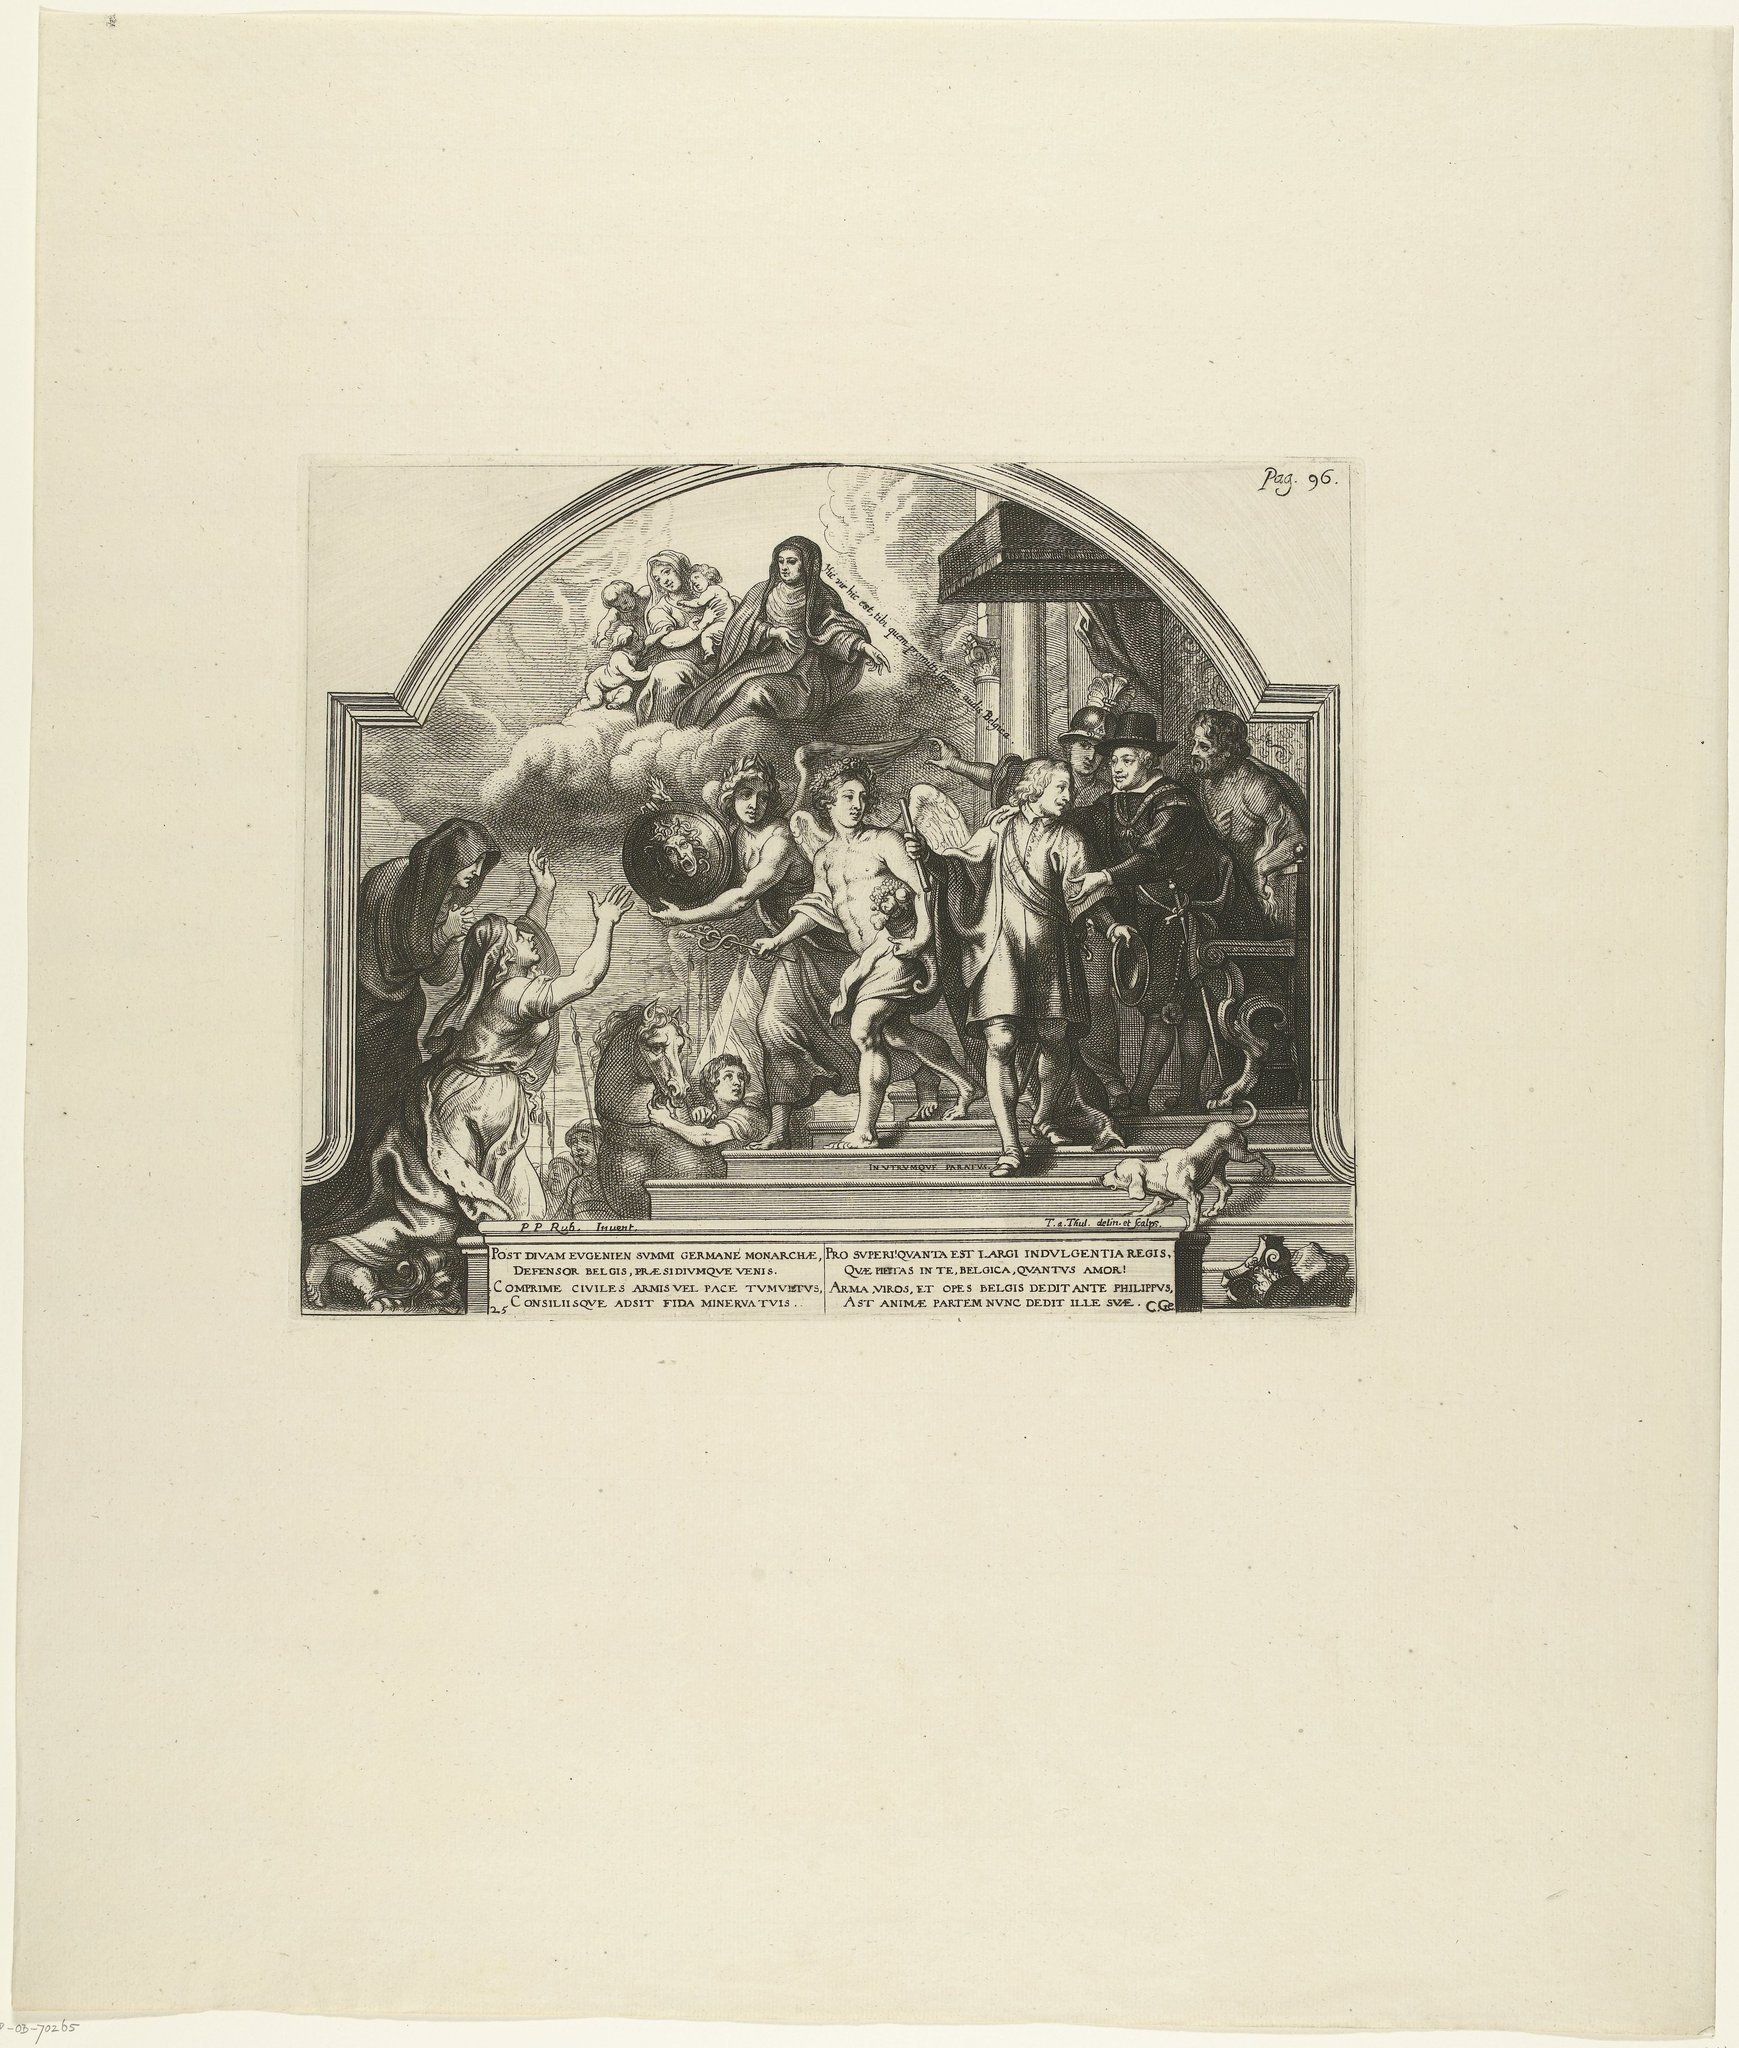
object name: print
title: Apotheosis D. Isabellae Clarae Eugeniae (...) Media Pegmatis Tab. maiori formâ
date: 1639-1641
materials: paper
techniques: engraving, etching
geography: southern netherlands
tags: filips iv (koning van spanje), infante van spanje isabella clara eugenia, brussels, landvoogd der zuidelijke nederlanden ferdinand van oostenrijk, triumphal arch, antwerp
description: De aanstelling van Ferdinand als gouverneur over de Nederlanden door Filips IV. Links de knielend smekende Nederlandse Maagd, in de hemel Isabella Clara Eugenia. De centrale voorstelling op de triomfboog van Isabella Clara Eugenia opgesteld in de Clarenstraat. Gemerkt rechtsboven: pag. 96. Blad nr. 25 in een geheel van 43 platen die de uitgave van de beschrijving van de intocht van de Kardinaal Infant Ferdinand van Oostenrijk te Antwerpen op 17 april 1635 als de nieuwe landvoogd voor de Spaanse Nederlanden illustreren.